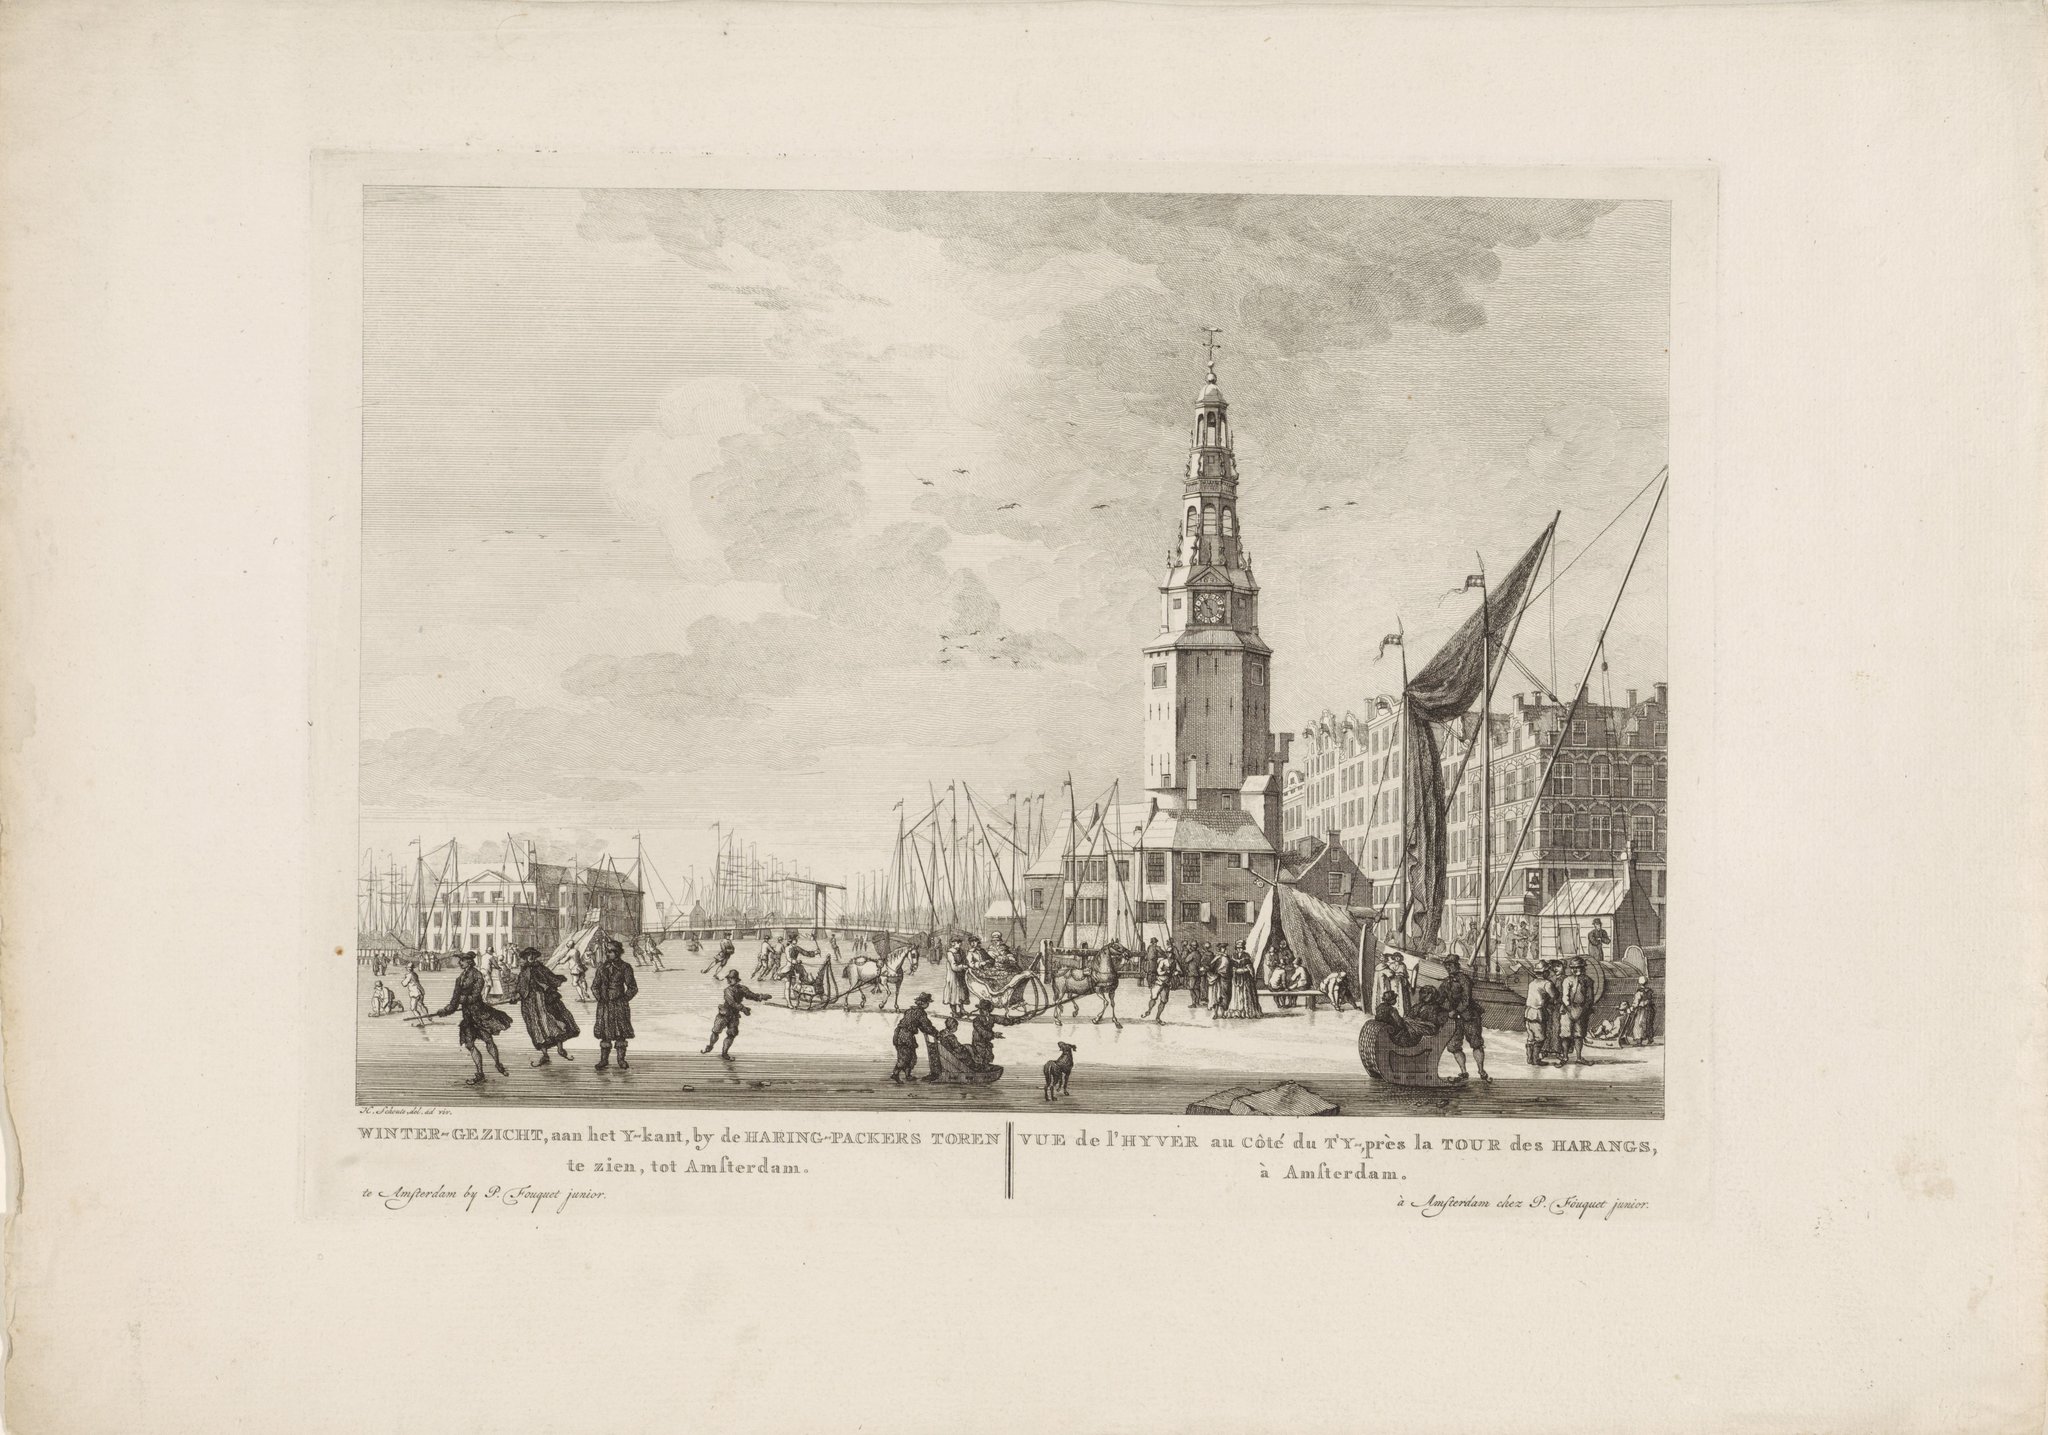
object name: print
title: Wintergezicht bij de Haringpakkerstoren te Amsterdam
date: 1770-1783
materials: paper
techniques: engraving, etching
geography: amsterdam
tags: bridge in city across river, canal, etc. (+ city(-scape) with figures, staffage), horse-sleigh, winter ~ human activities (the four seasons of the year), skates (winter sports), sledge, sleigh (winter sports), canals, waters (in city) (+ city(-scape) with figures, staffage)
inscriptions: collector's mark: Lugt 2233, collector's mark: Lugt 2228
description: Deze prent is ook gebruikt in de zogenaamde Atlas van Fouquet.* Pierre Fouquet gaf vanaf 1760 stadsgezichten van Amsterdam - naar tekeningen van verschillende kunstenaars, gemaakt door verschillende prentmakers - uit. Deze prenten werden aanvankelijk los of in series verkocht. Zoals toen gebruikelijk kon de koper de prenten zelf laten inbinden. Hiertoe gaf Fouquet tussen 1778 en 1783 een titelblad, plattegrond en inhoudsopgave van de tot dusver 100 uitgegeven prenten uit (1). Gezien de inhoud afhankelijk was van wat de koper had verzameld verschilt de inhoud van de verschillende bewaarde Fouquetatlassen onder deze titel sterk. Ook zijn er exemplaren bekend waar tevens andere prenten aan zijn toegevoegd. Omdat er behoefte bleek aan uitleg bij de platen werd in 1783 een nieuwe versie van de atlas uitgegeven, aangevuld met tekst en twee prenten. De aangegeven volgorde veranderde maar de platen van de al eerder uitgegeven prenten bleven ongewijzigd. Deze uitgave werd in opdracht van Fouquet gedrukt bij Daniël Jean Changuion en Petrus den Hengst (2). Een tiental platen werd bijgewerkt en verscheen, met nieuw impressum, in het vervolg van Wagenaars geschiedenis van Amsterdam, uitgeven door Petrus Conradi en Folkert van der Plaats (3). Een aantal jaar na het overlijden van Fouquet kwam Evert Maaskamp met een nieuwe uitgave van de atlas, met verbeterde tekst en toevoeging van twee prenten. Op alle platen verwijderde hij het oude en liet hij zijn eigen impressum zetten (4). De huidige staat van de prent komt voor in exemplaren van de onder (1) en (2) genoemde werken. * Onder de Atlas van Fouquet of Fouquetatlas verstaan we de hieronder vermelde publicaties (1), (2) en (4). (1). Afbeeldingen van de wyd-vermaarde koopstad Amsterdam benevens des zelvs voornaamste gebouwen en gezigten alle naar het leeven getekend / Receuil des edifices les plus considerables et des plus belles vues, de la fameuse ville d'Amsterdam, dessinées d'après nature. Amsterdam: Pierre Fouquet, 1778-1783. (2). Nieuwe atlas, van de voornaamste gebouwen en gezigten der stad Amsterdam, met derzelver beknopte beschryvingen. 2 delen. Amsterdam: Daniël Jean Changuion en Petrus den Hengst [in opdracht van Pierre Fouquet], 1783. (3). Stijl, Simon. Amsterdam, in zyne geschiedenissen, voorregten, koophandel, gebouwen, kerkenstaat, schoolen, schutterye, gilden en regeeringe, beschreeven. Om te dienen ten vervolge op het werk van Jan Wagenaar (…). 10 delen. Amsterdam en Harlingen: Petrus Conradi en Folkert van der Plaats, 1788-1801. (4). Nieuwe atlas, van de voornaamste gebouwen en gezigten der stad Amsterdam. Met derzelver beknopte beschryvingen. Amsterdam: Evert Maaskamp, 1805. * Het aantal vermelde staten is gebaseerd op het aantal gevonden staten. Mogelijk zijn er meer staten van deze prent. Zie RP-P-AO-27-34A voor tweede bekende staat.